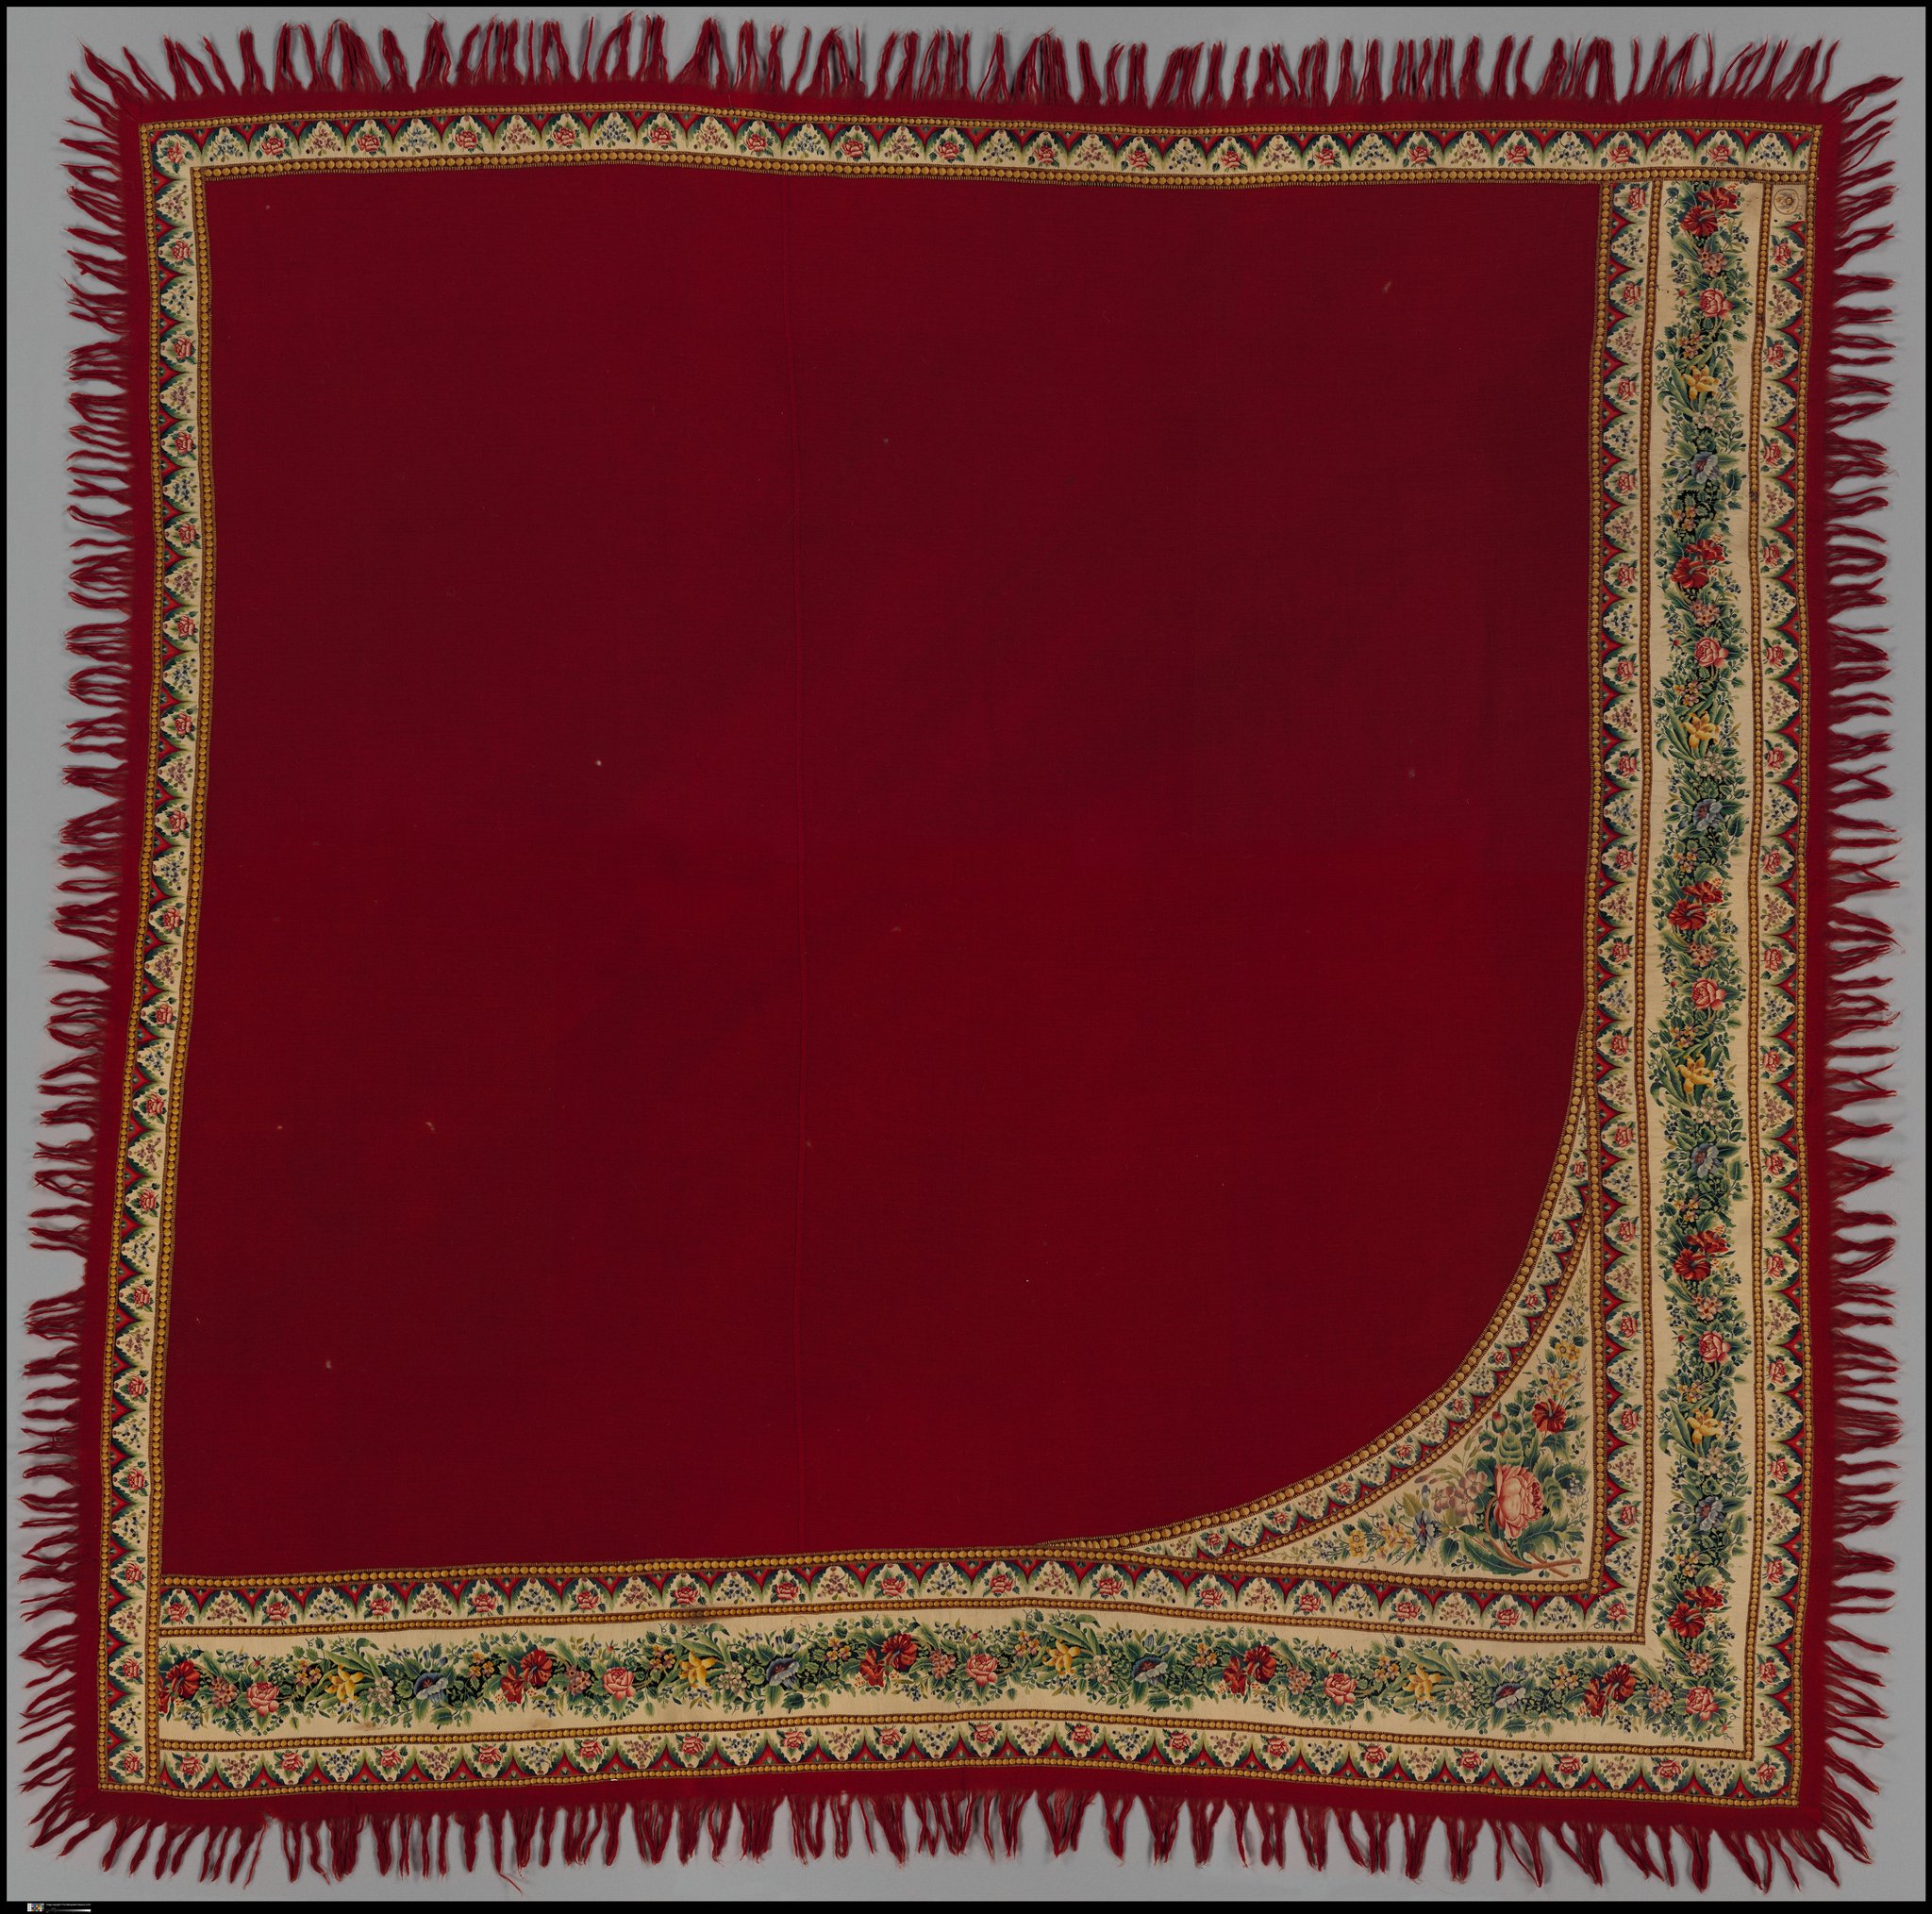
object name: shawl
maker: dimitri kolokoltzev manufactory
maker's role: manufactory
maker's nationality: russian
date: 1830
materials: wool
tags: flowers